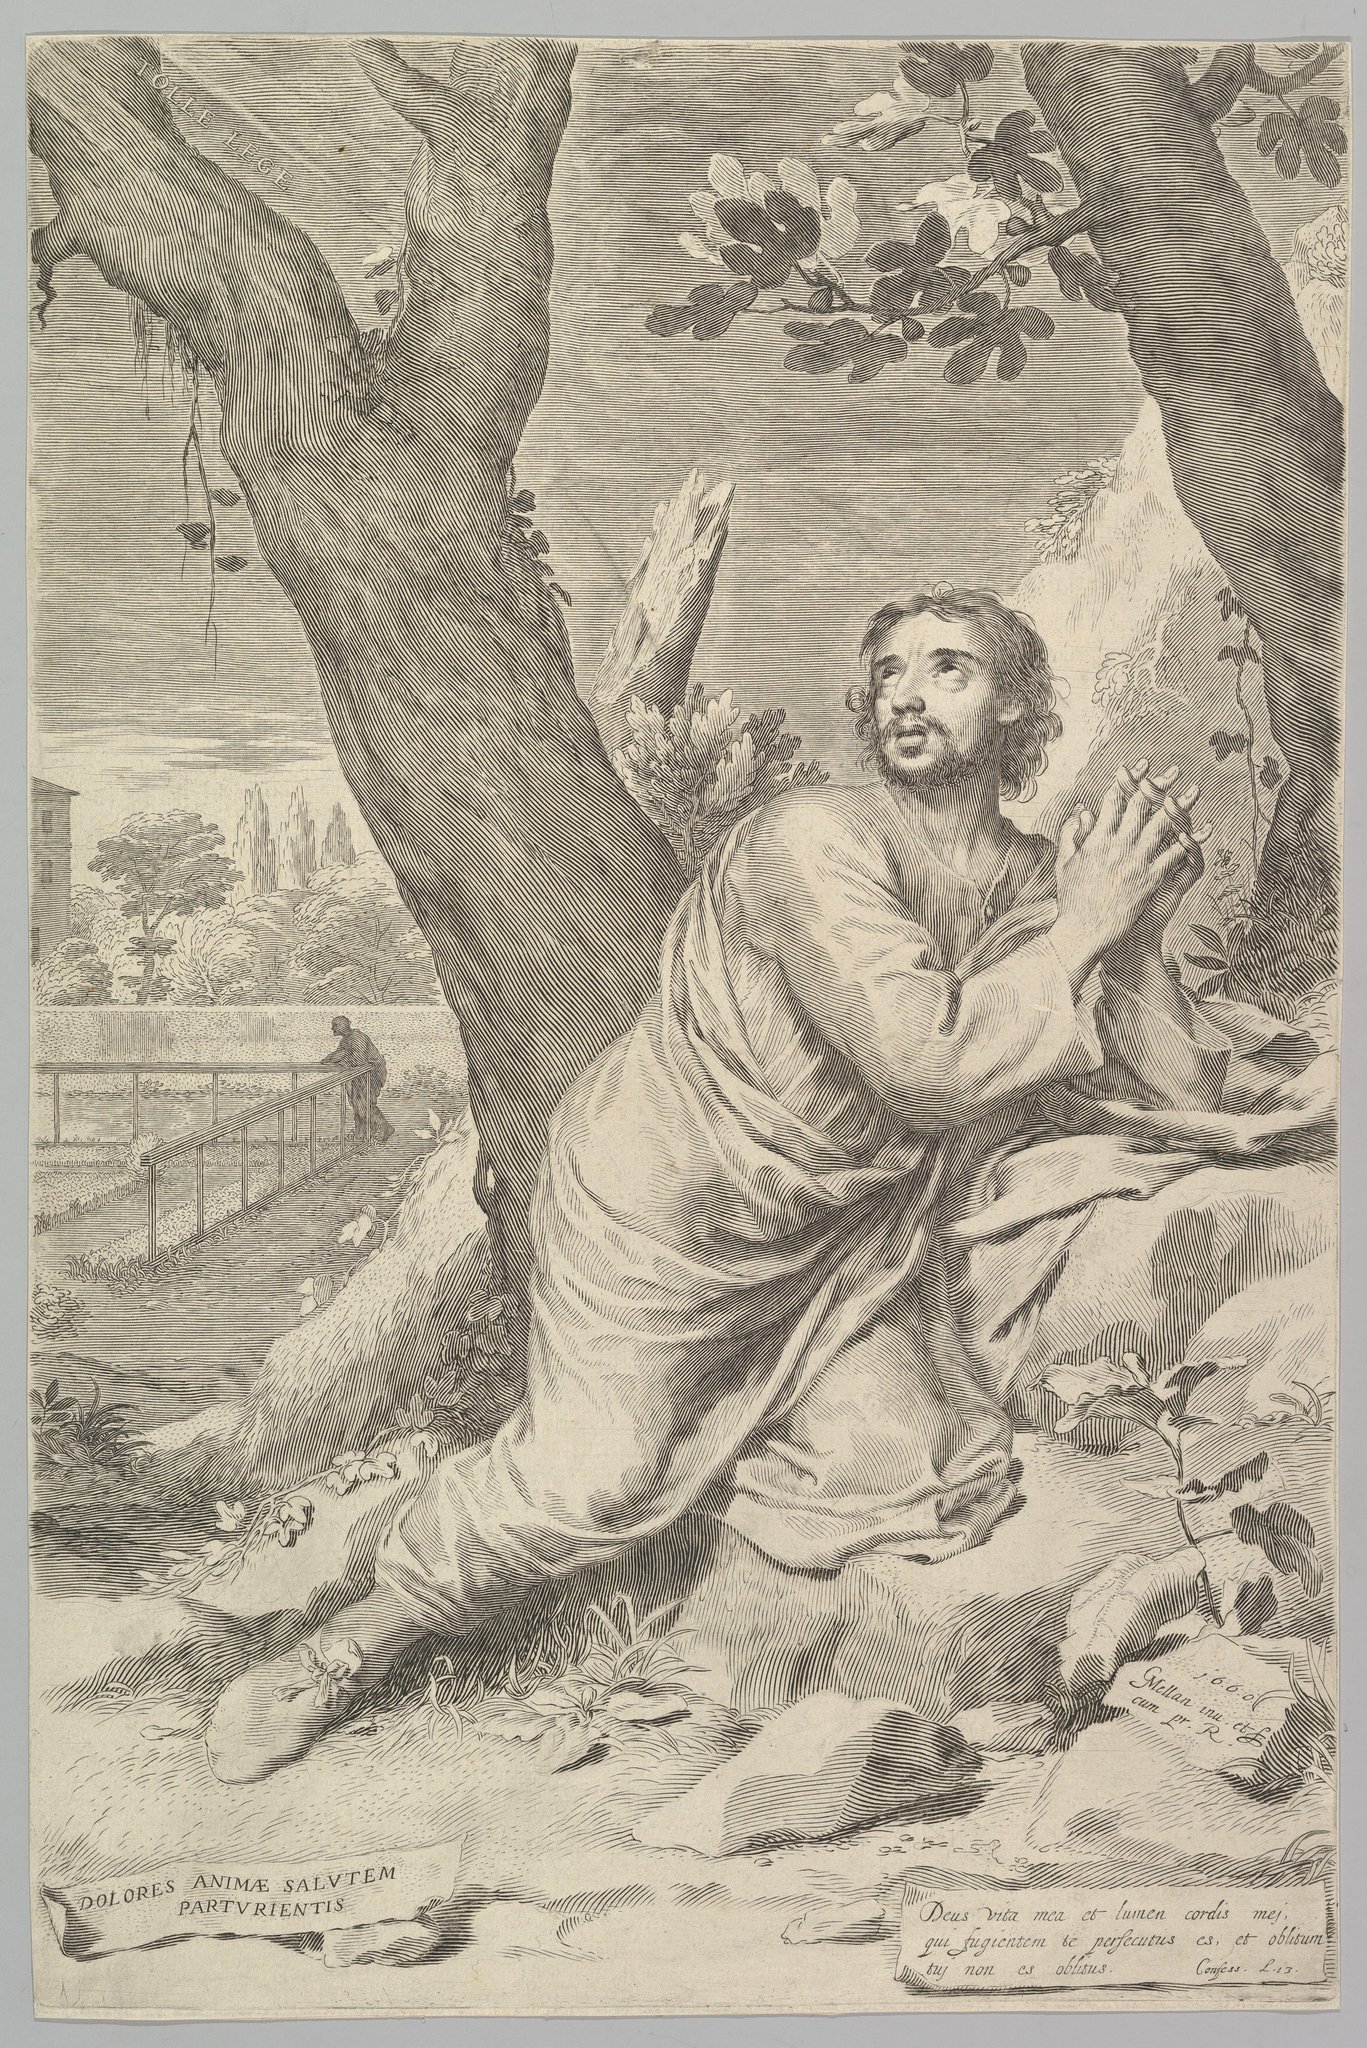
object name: print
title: St. Augustine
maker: claude mellan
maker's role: artist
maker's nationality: french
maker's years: 1598-1688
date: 1660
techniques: engraving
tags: men,trees,saints